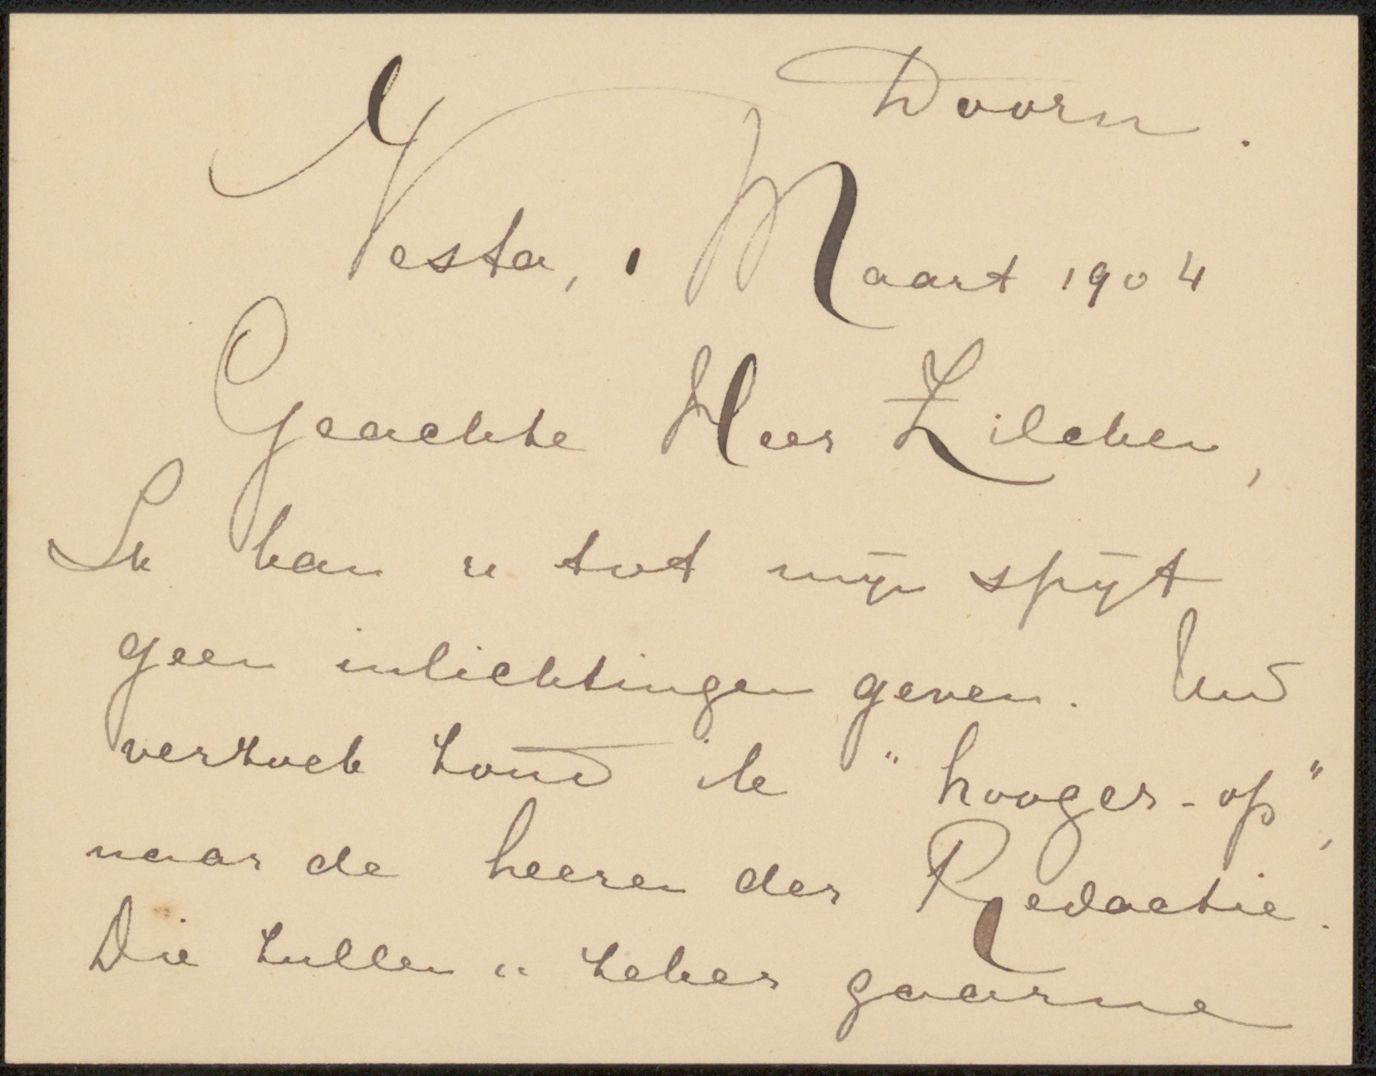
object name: letter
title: Brief aan Philip Zilcken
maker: a. smit kleine-fastré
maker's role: schrijver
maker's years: 1856-1924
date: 1904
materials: cardboard, ink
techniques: pen, writing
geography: doorn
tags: the hague, painter, draughtsman, philip zilcken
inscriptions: collector's mark: ‘RPK’